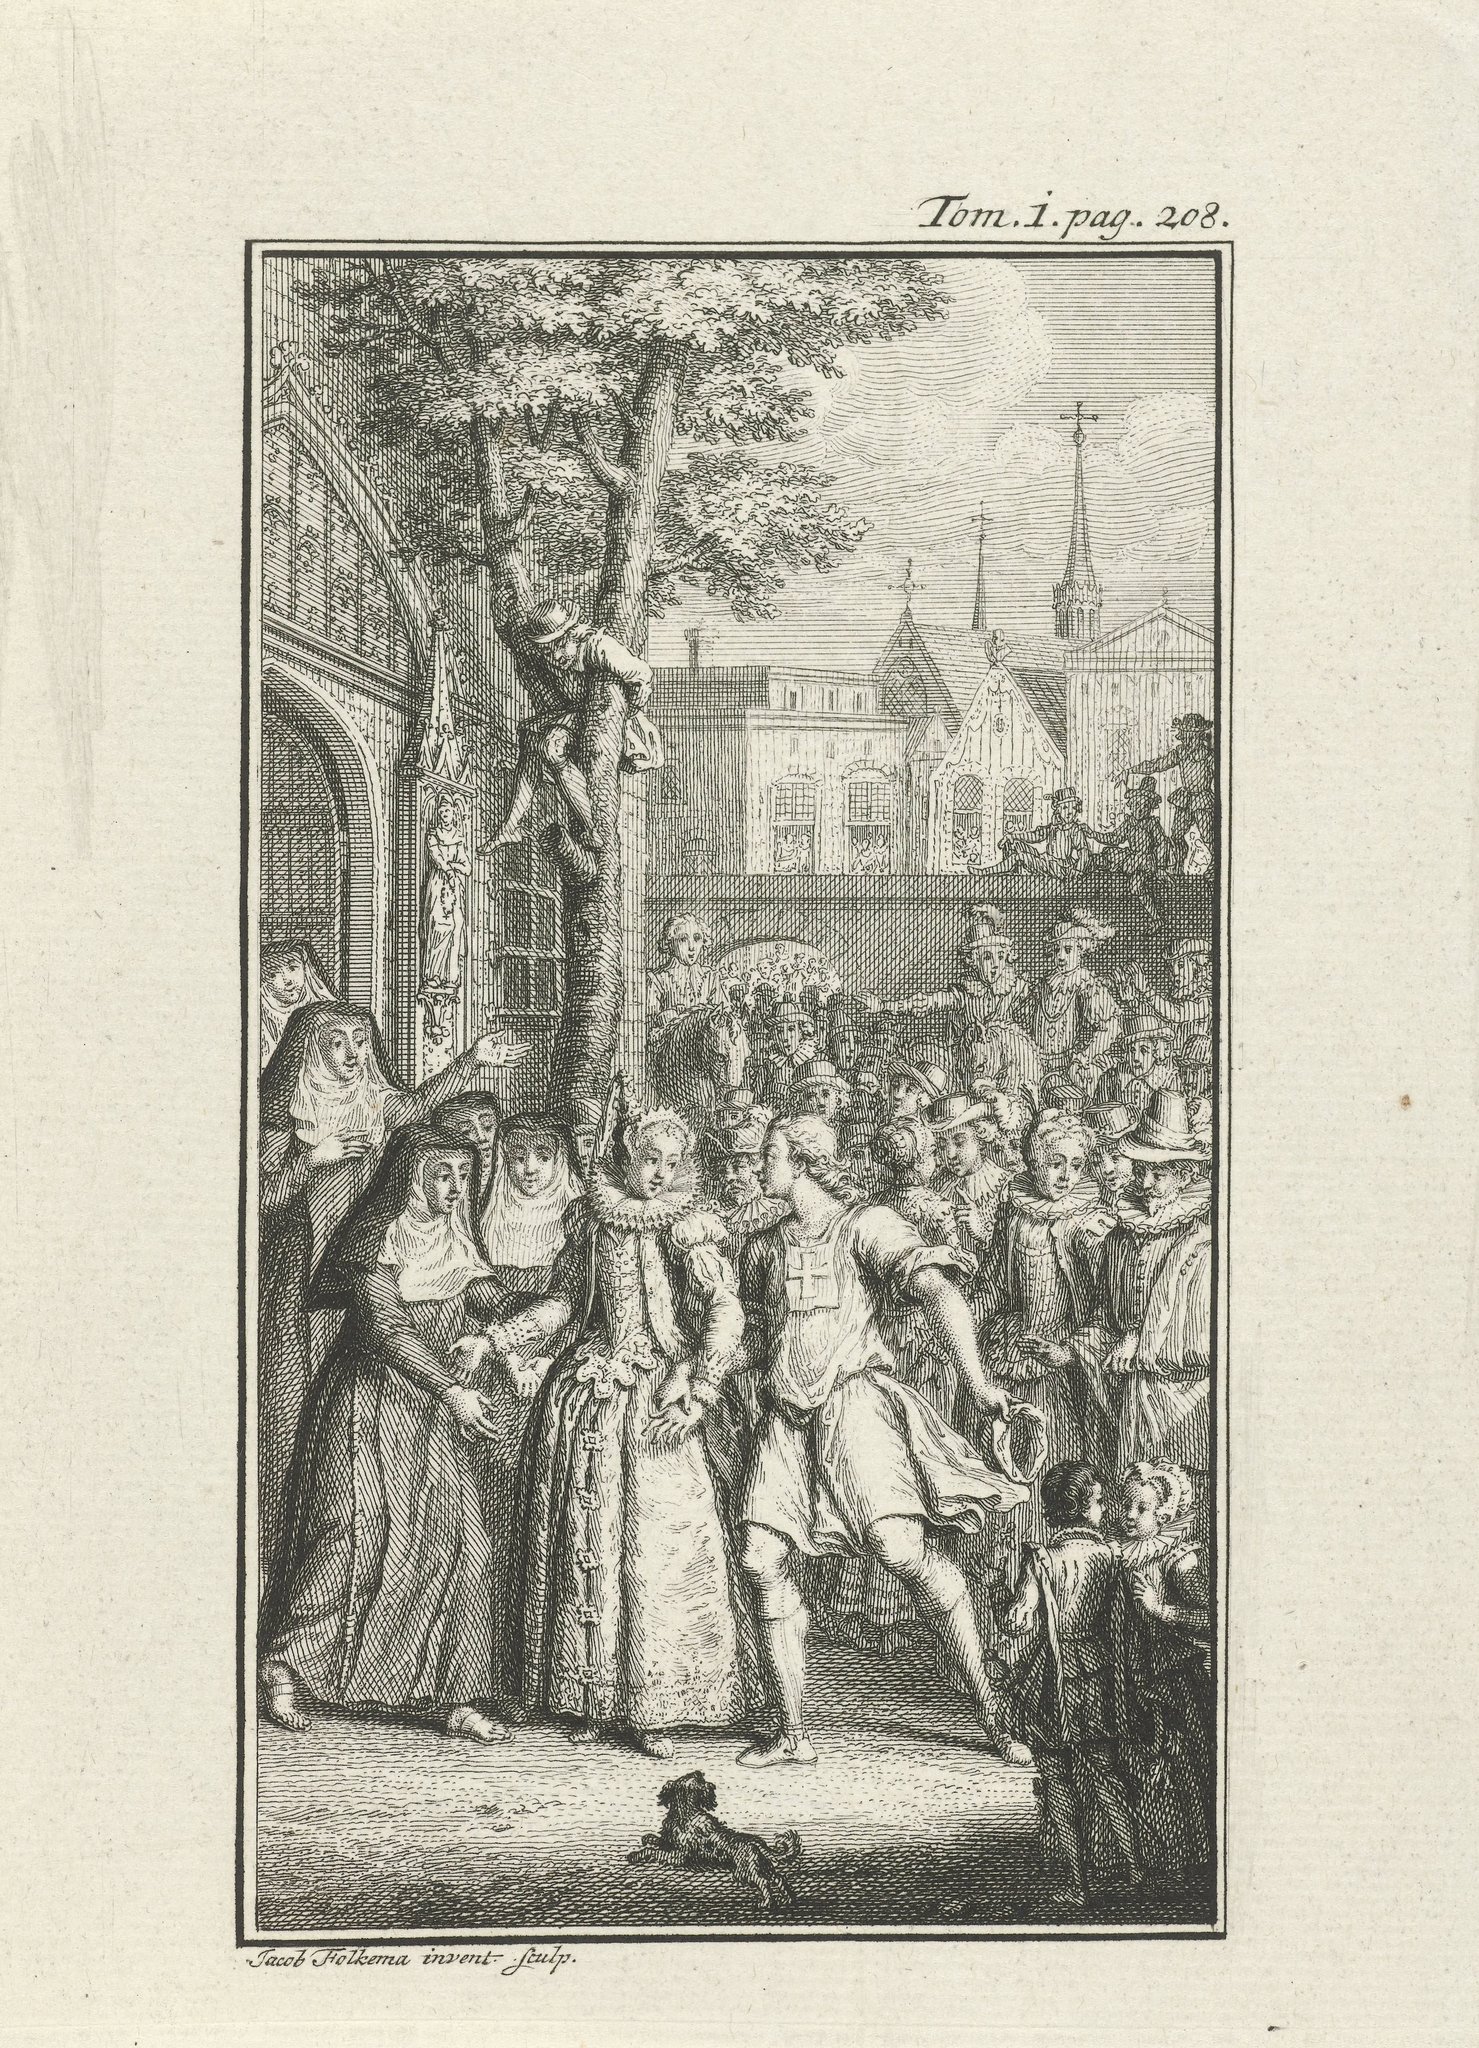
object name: print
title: Rijk geklede vrouw omringd door een menigte nieuwsgierige mensen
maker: jacob folkema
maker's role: draughtsman, print maker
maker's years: 1692-1767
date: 1702-1767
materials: paper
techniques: etching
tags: crowd, mob, nun(s)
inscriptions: collector's mark: Lugt 2228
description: Een rijk geklede vrouw staat tussen een groepje nonnen en een jongeman in. Laatstgenoemde heeft zijn hoed voor de vrouw afgenomen en haar hand vastgepakt. Op de achtergrond heeft een nieuwsgierige menigte zich verzameld. Prent rechtsboven gemerkt: Tom. i. pag. 208.